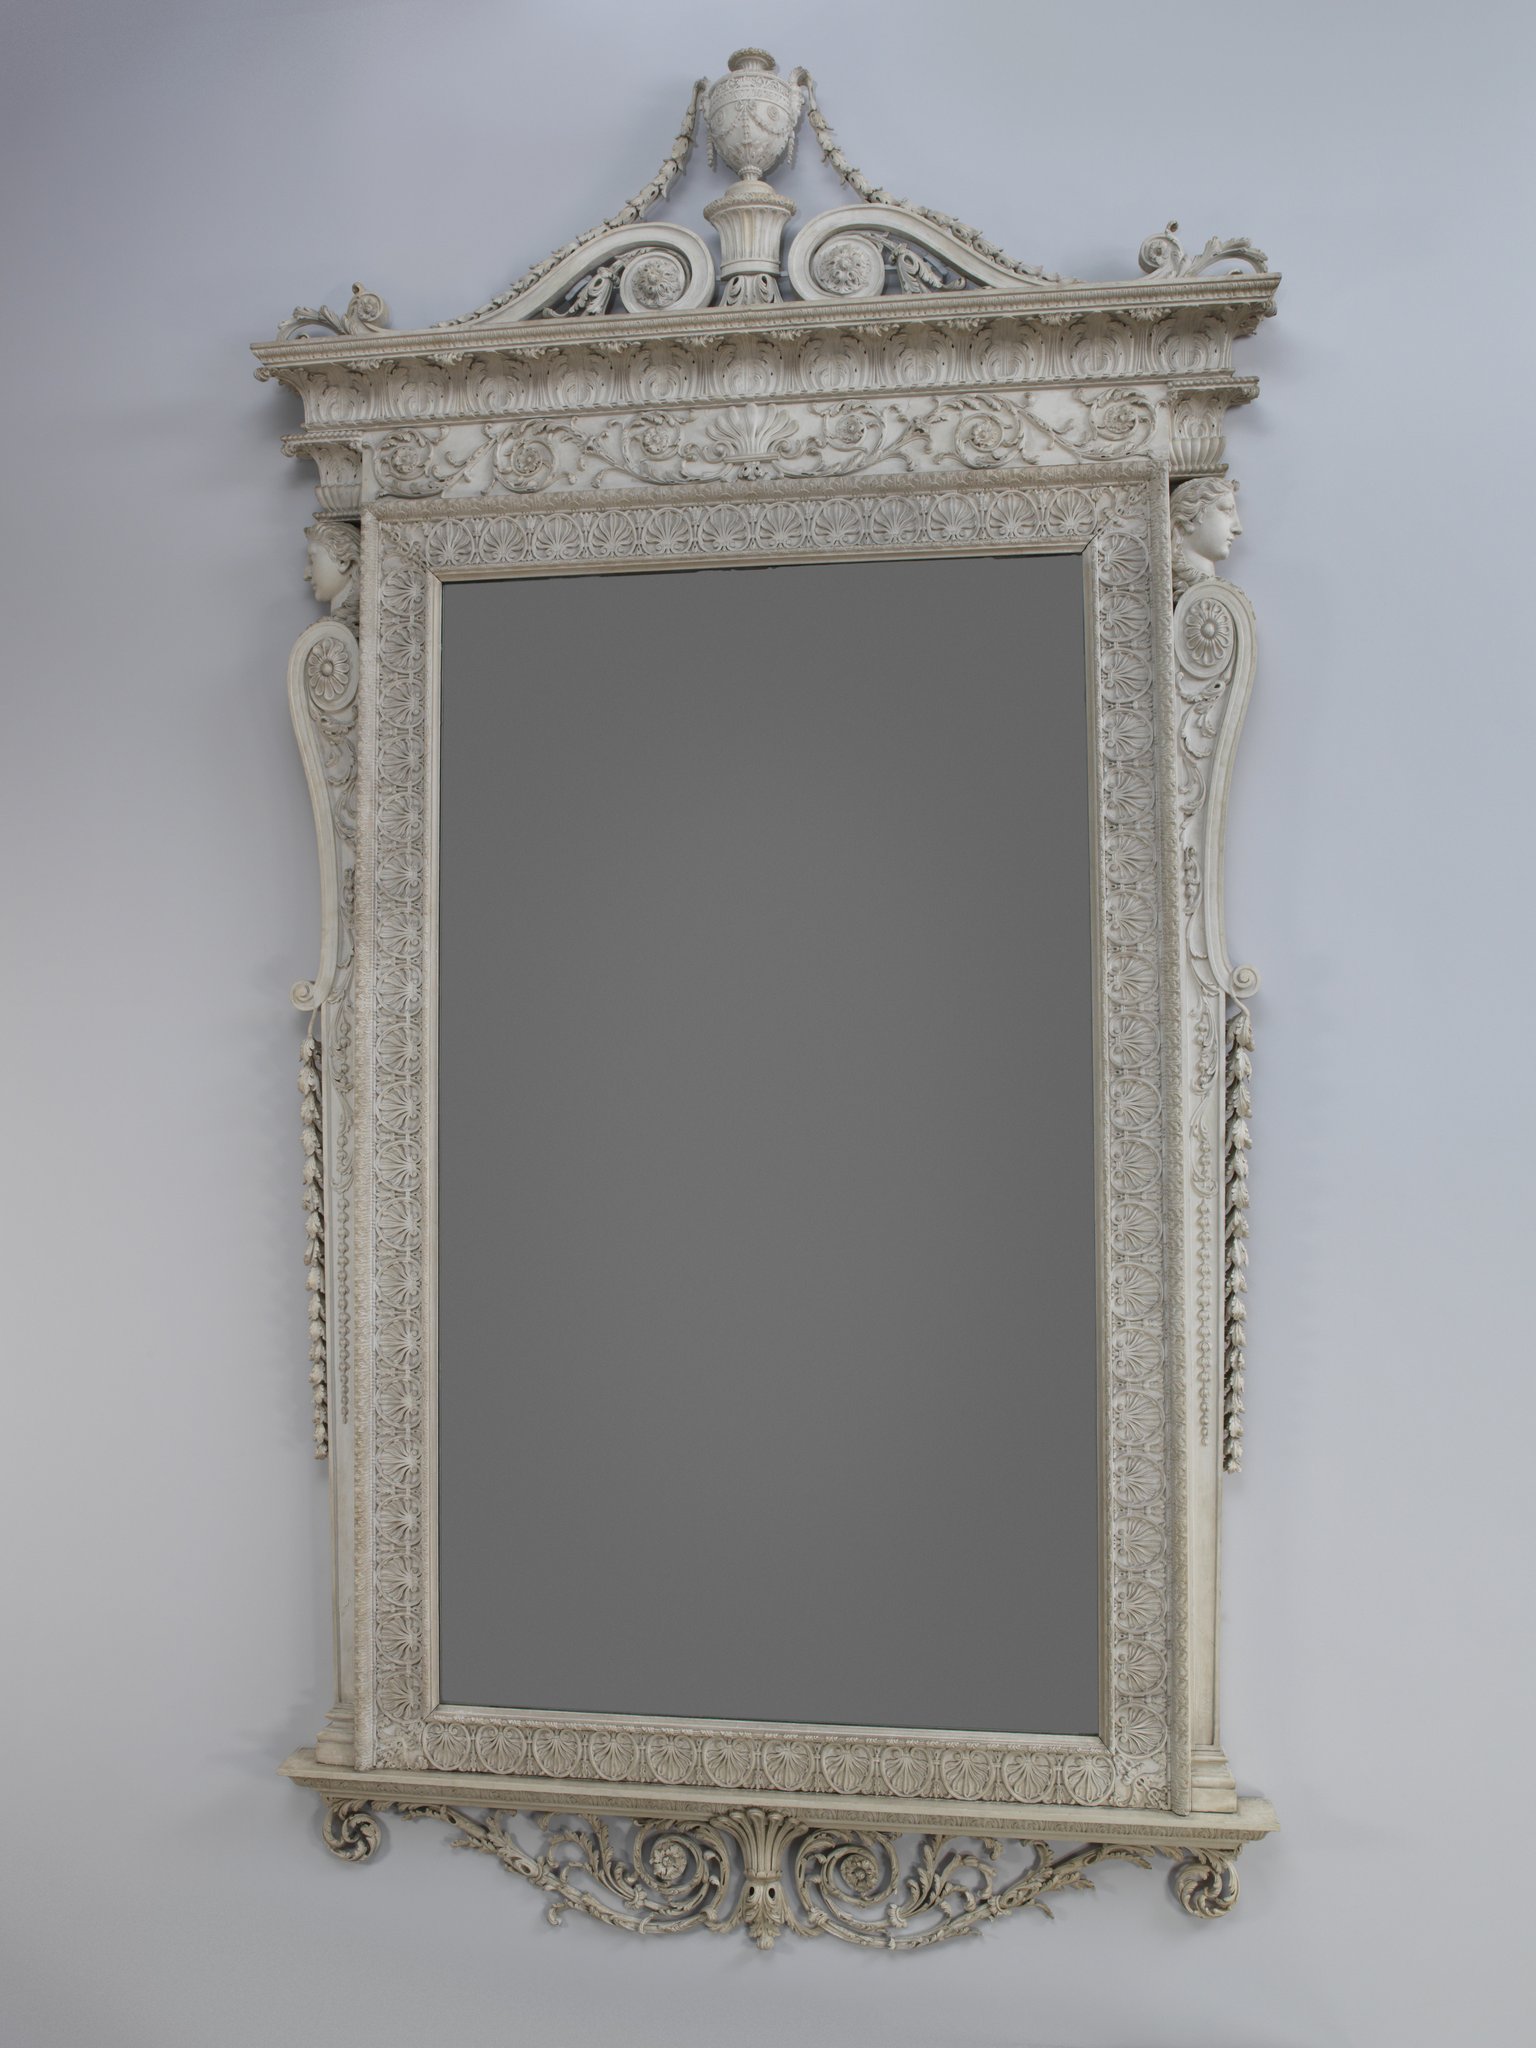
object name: mirror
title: Mirror from Croome Court, Worcestershire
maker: robert adam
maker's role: designer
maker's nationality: british, scottish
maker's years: 1728-1792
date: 1765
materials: cement, marble, wood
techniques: carving, painting, veneering